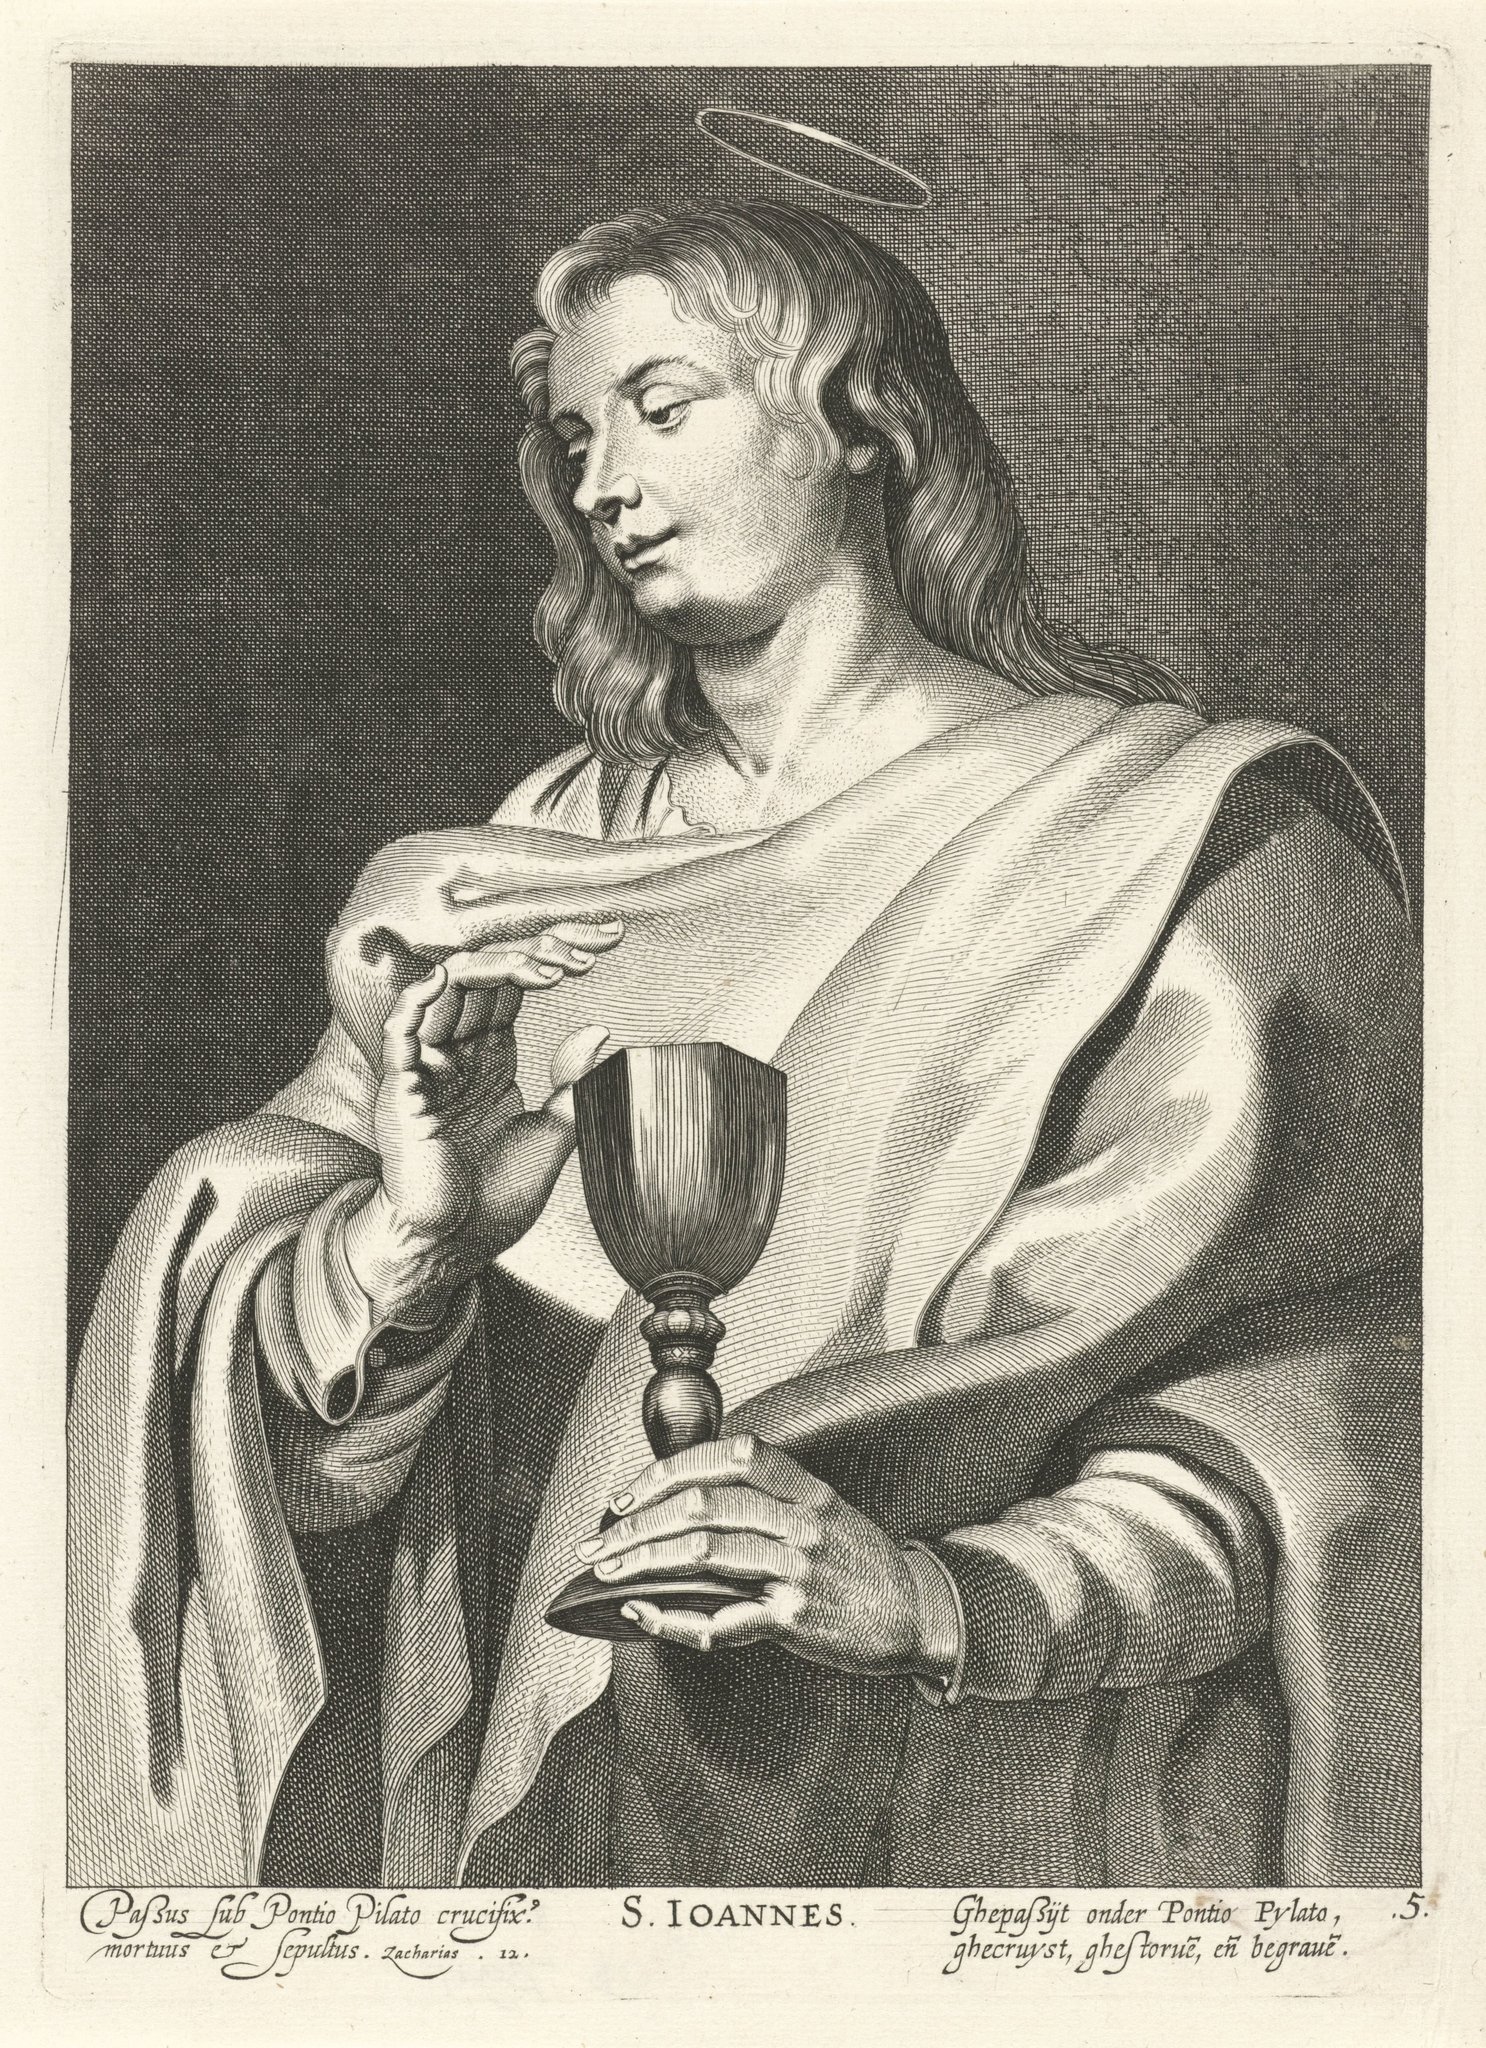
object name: print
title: Christus en dertien apostelen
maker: nicolaes ryckmans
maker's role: print maker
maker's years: 1595-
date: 1616-1636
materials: paper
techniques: engraving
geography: southern netherlands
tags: the apostle john the evangelist; possible attributes: book, cauldron, chalice with snake, eagle, palm, scroll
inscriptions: collector's mark: Lugt 240